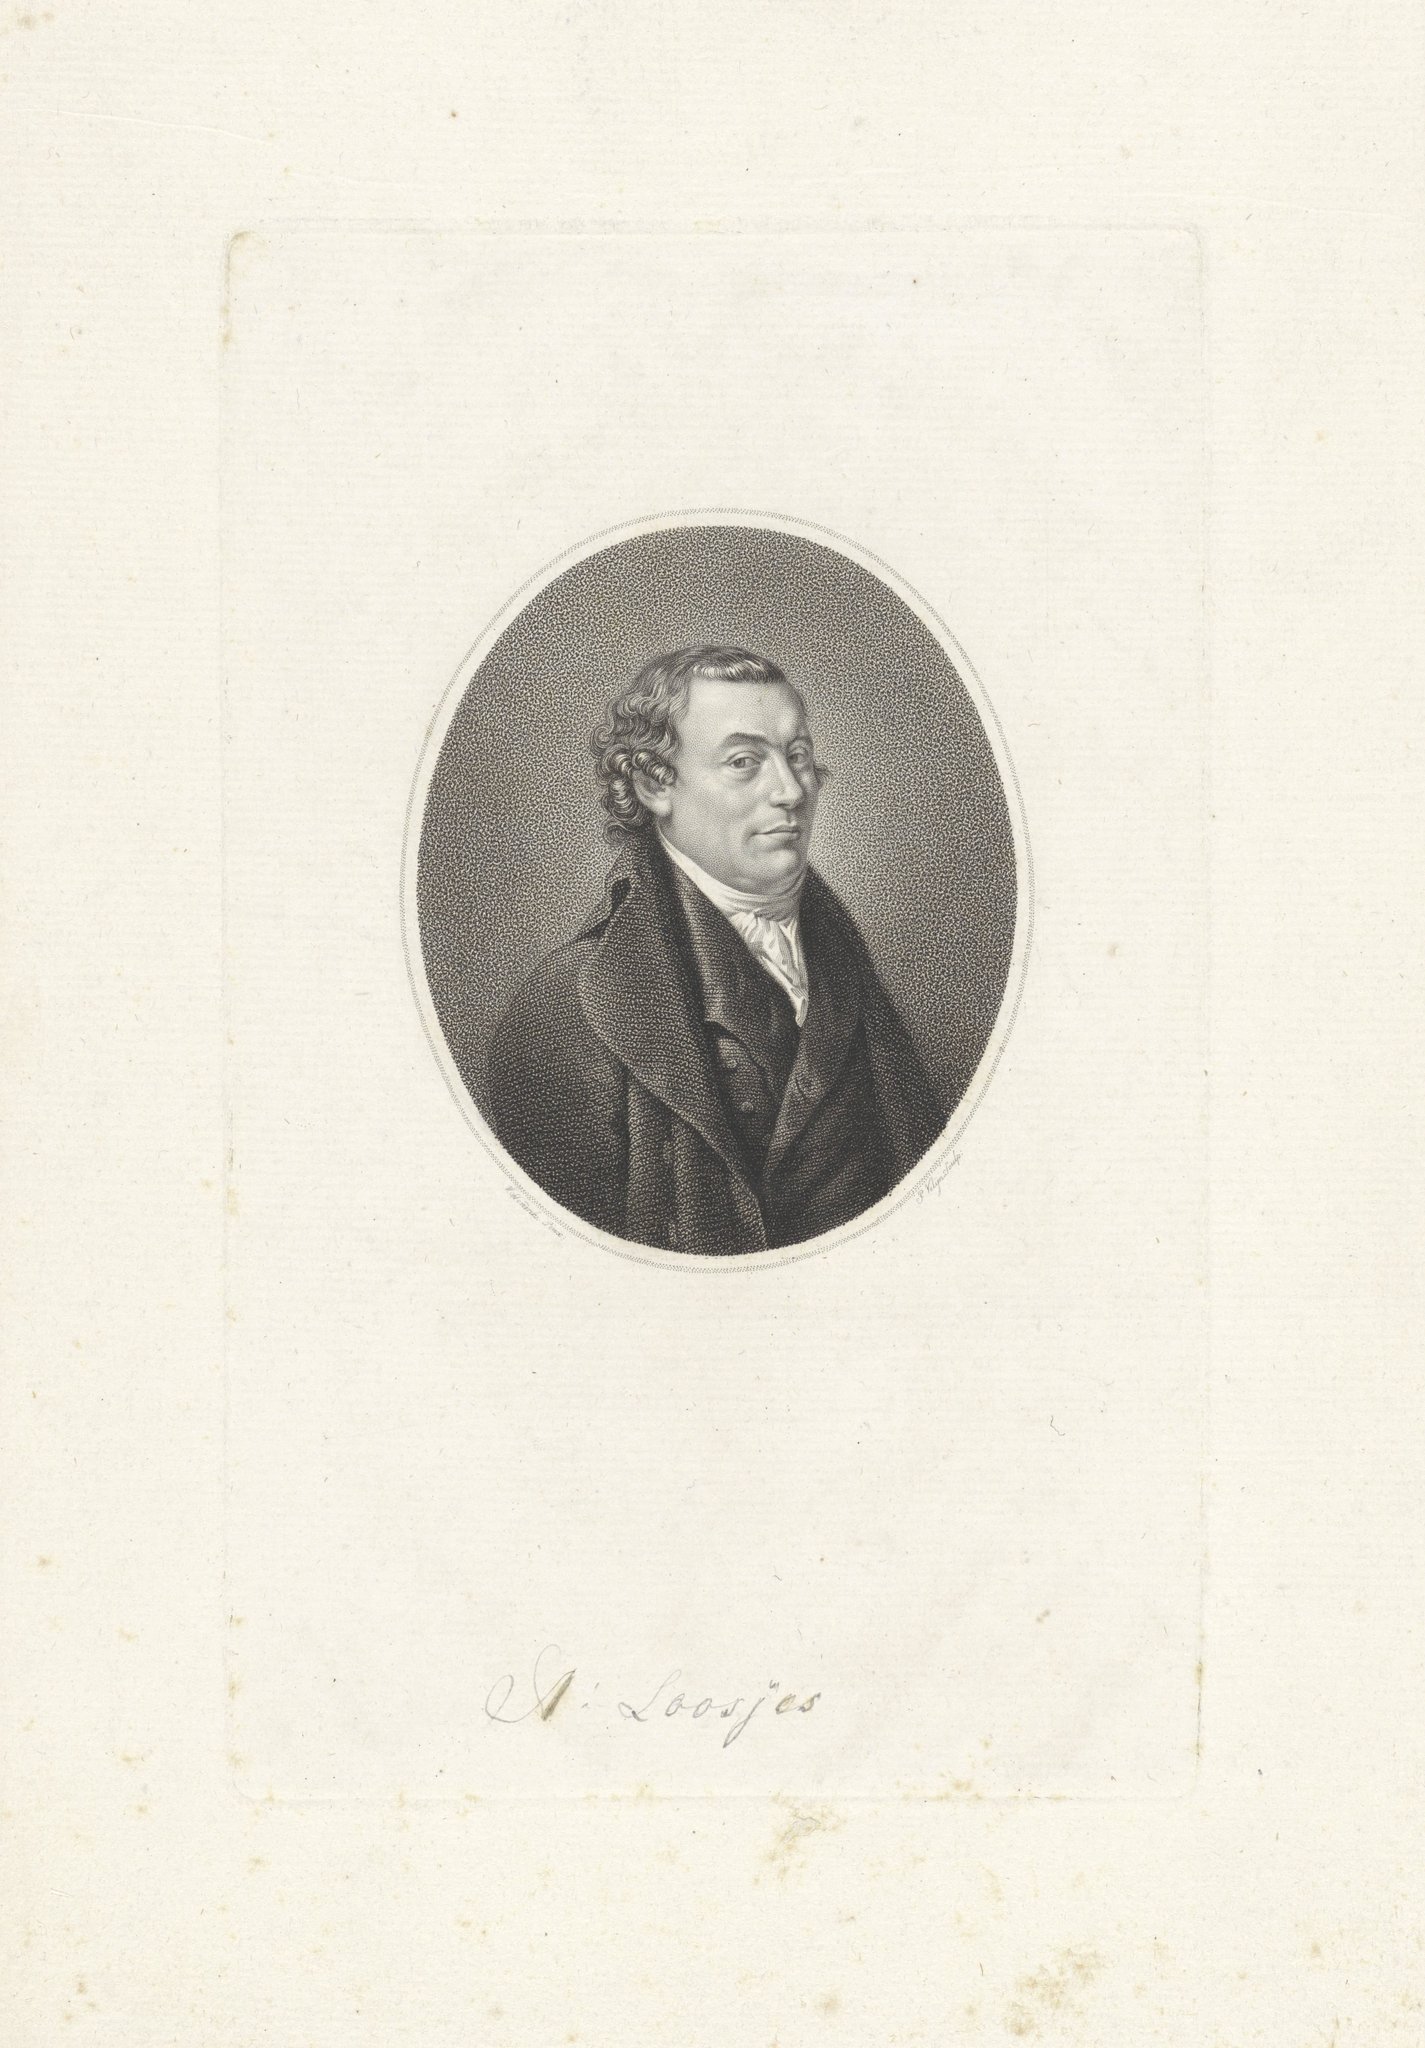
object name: print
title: Portret van Adriaan Pietersz. Loosjes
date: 1797-1836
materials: paper, pencil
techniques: engraving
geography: netherlands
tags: haarlem, publisher, bookseller, adriaan pietersz. loosjes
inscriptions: name: ‘A:Loosjes’, collector's mark: Lugt 2233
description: Portret van Adriaan Pietersz. Loosjes, uitgever en boekverkoper te Haarlem.